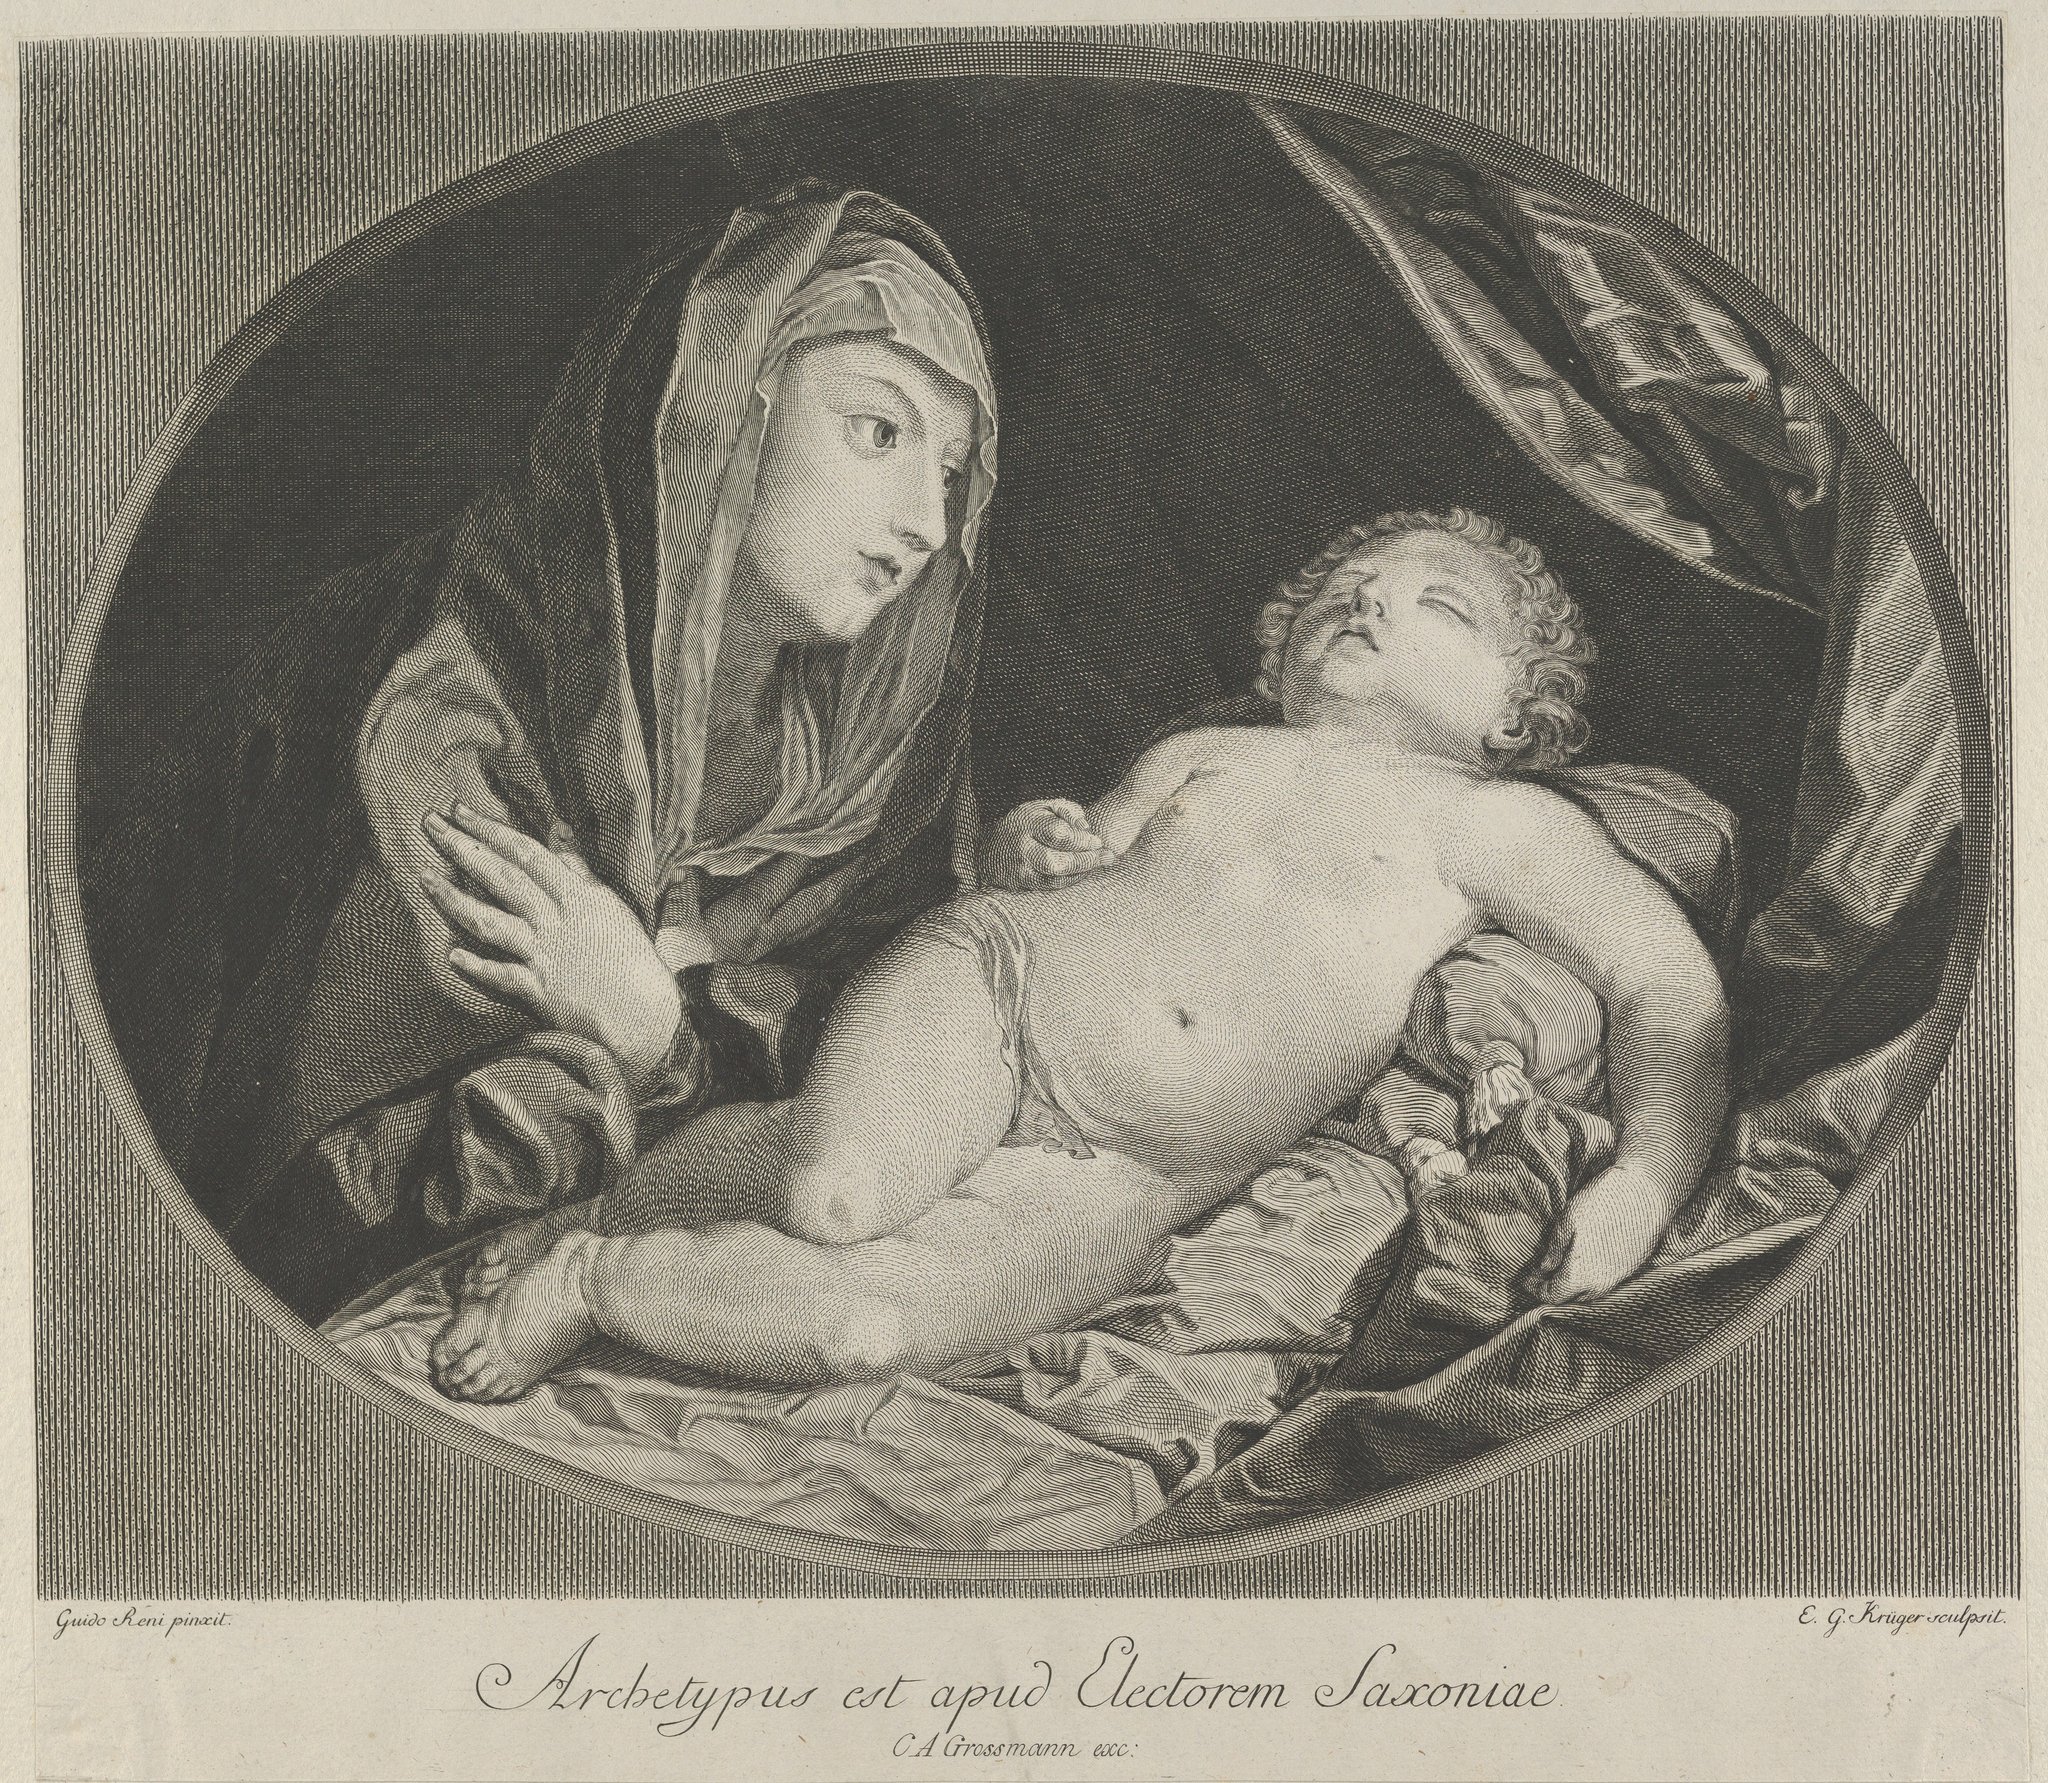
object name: print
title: The Virgin with arms crossed over her chest looking at the sleeping infant Christ, in an oval frame, after Reni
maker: ephraim gottlieb krüger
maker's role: artist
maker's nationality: german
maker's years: 1756-1834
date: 1770-1834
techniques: engraving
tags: sleeping,christ,virgin mary